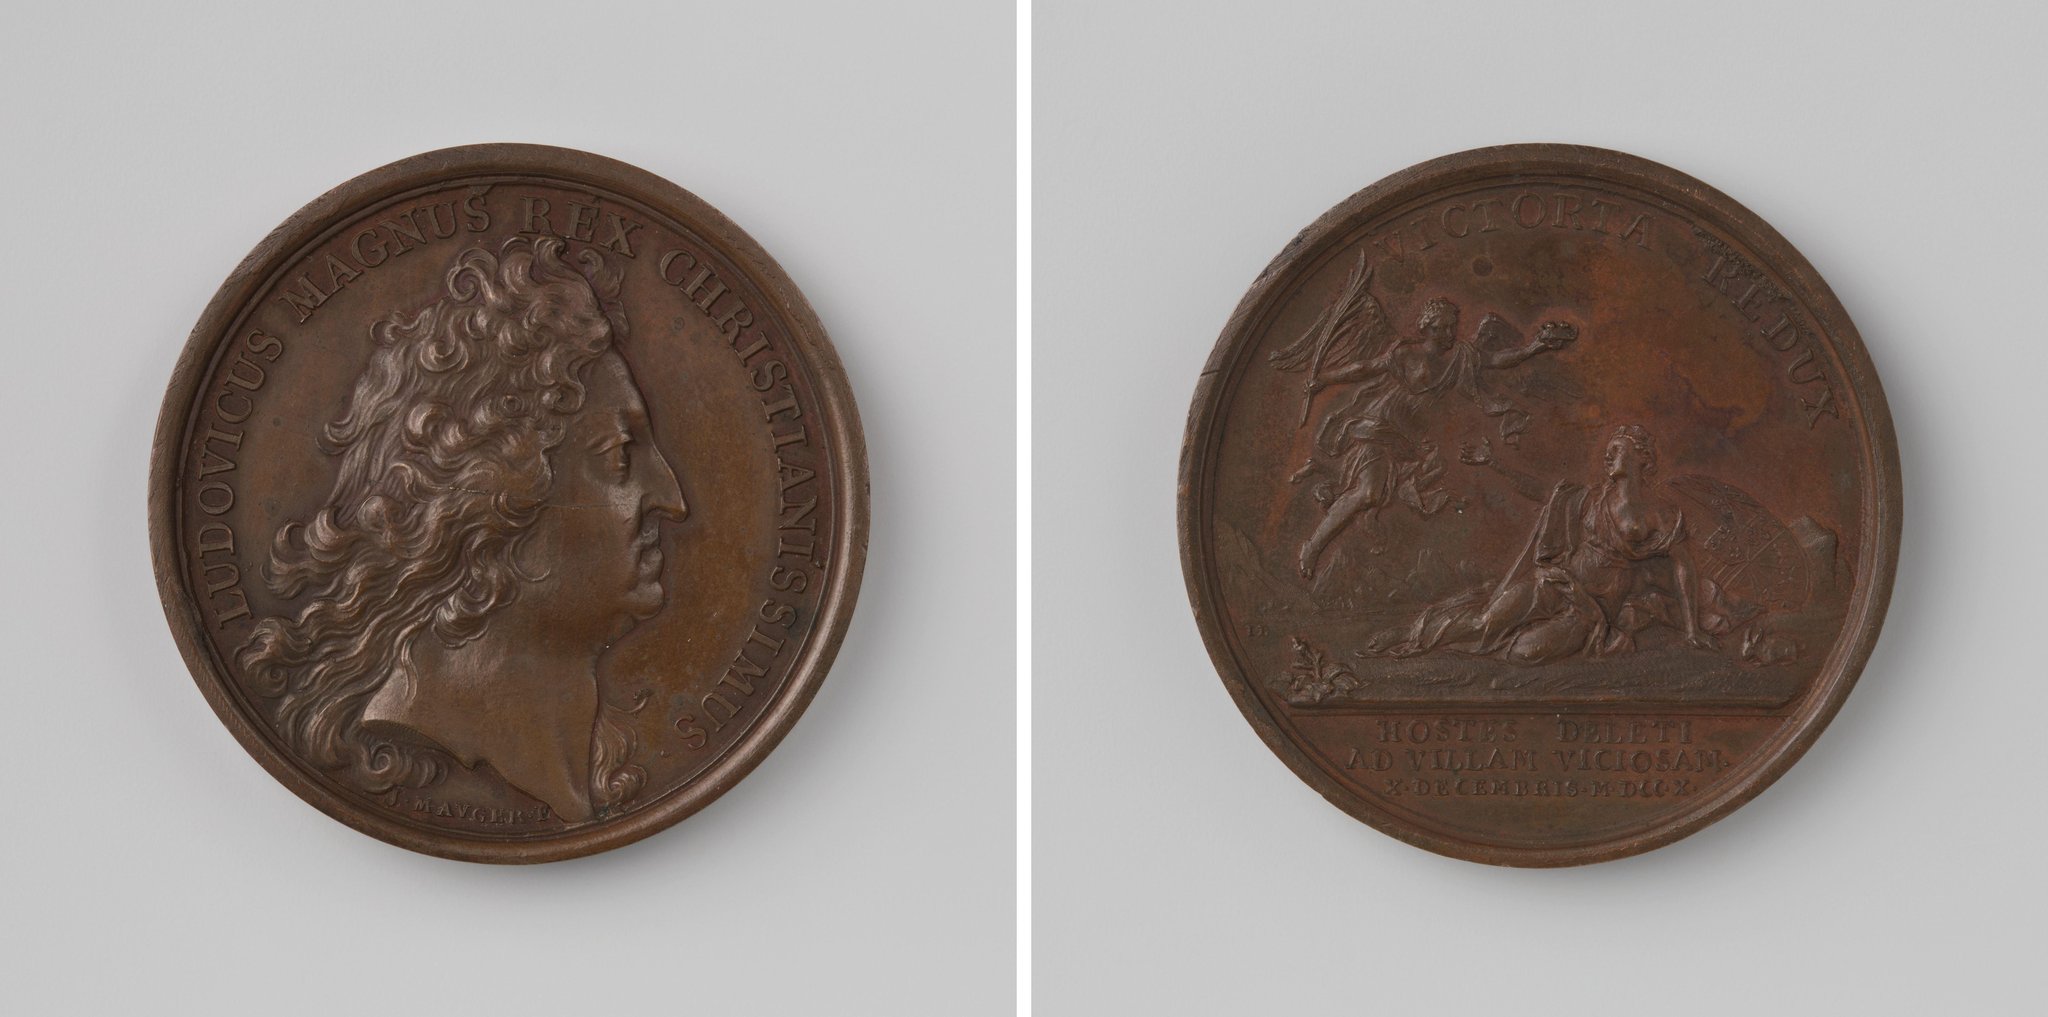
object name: history medal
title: Overwinning van de Fransen bij Villaviciosa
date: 1710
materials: bronze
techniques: striking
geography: paris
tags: lodewijk xiv (koning van frankrijk)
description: Bronzen penning. Voorzijde: borststuk man binnen omschrift. Keerzijde: gevleugelde Overwinning met kroon en zegetak in handen vliegt boven ter aarde liggende vrouw, voorstellende Spanje, daarnaast gras etend konijntje binnen omschrift; afsnede: opschrift.